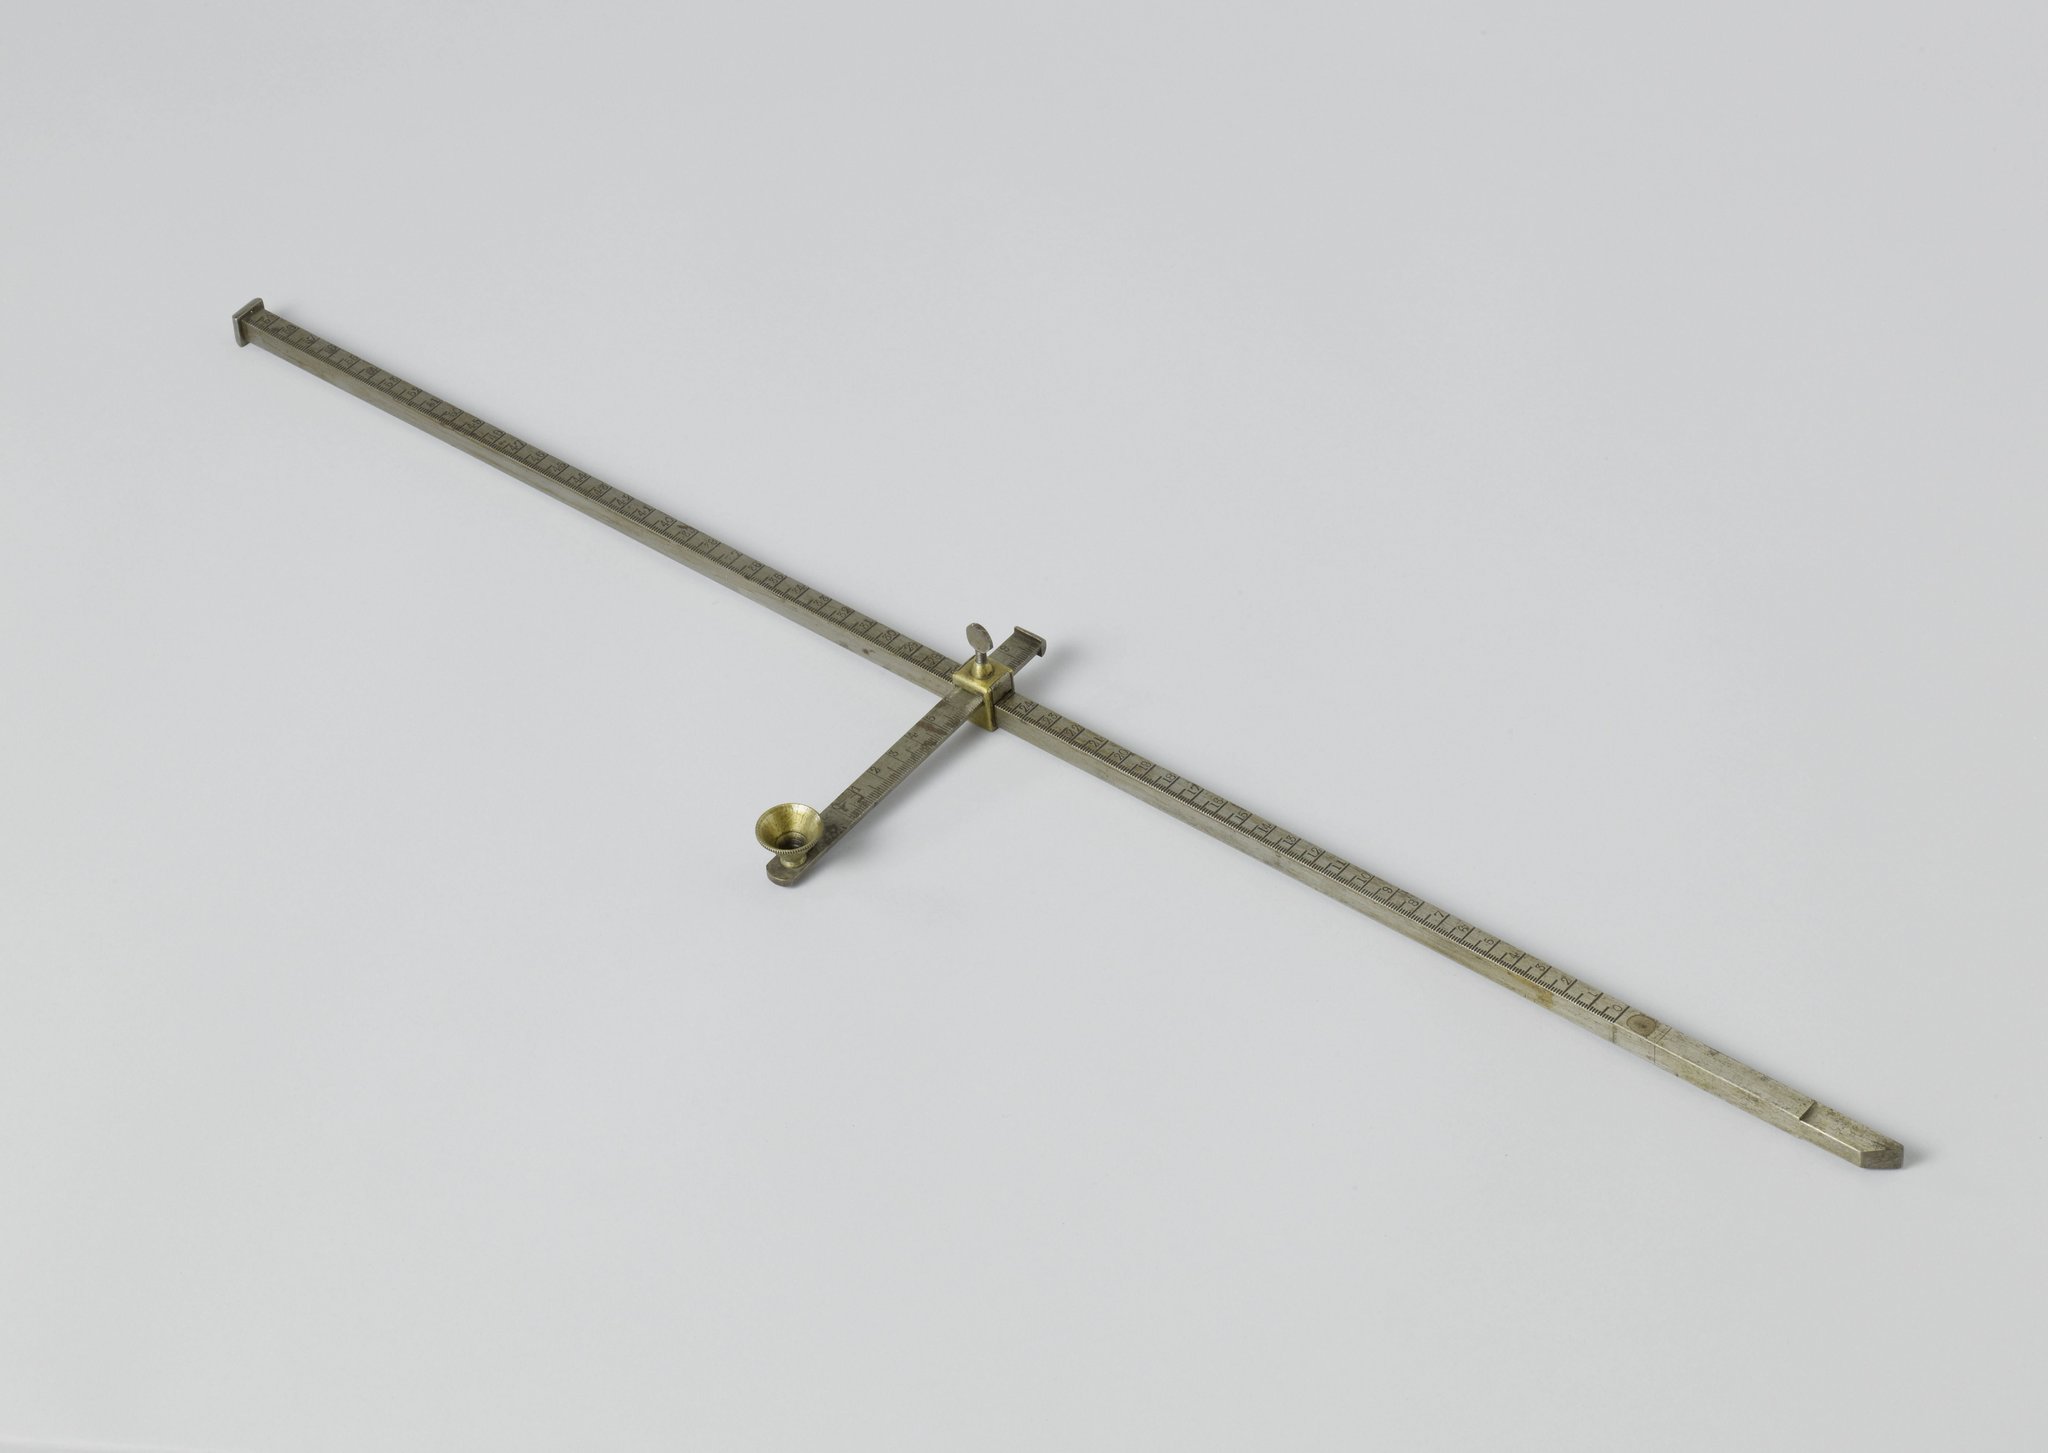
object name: tangent sight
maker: Anonymous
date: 1864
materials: brass, iron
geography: netherlands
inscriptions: inscription, on the tapered edge: ‘K / B1’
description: Opzetstang voor een 16 cm getrokken kanon, bestaande uit een ijzeren staaf met pyramidevormige top, waarop een korte horizontale staaf met oculair aan het uiteinde is bevestigd. De horizontale staaf kan zowel verticaal als horizontaal ingesteld worden. De verticale staaf is onderverdeeld in 600 mm, de horizontale in 100 mm. Schaal 1:1.